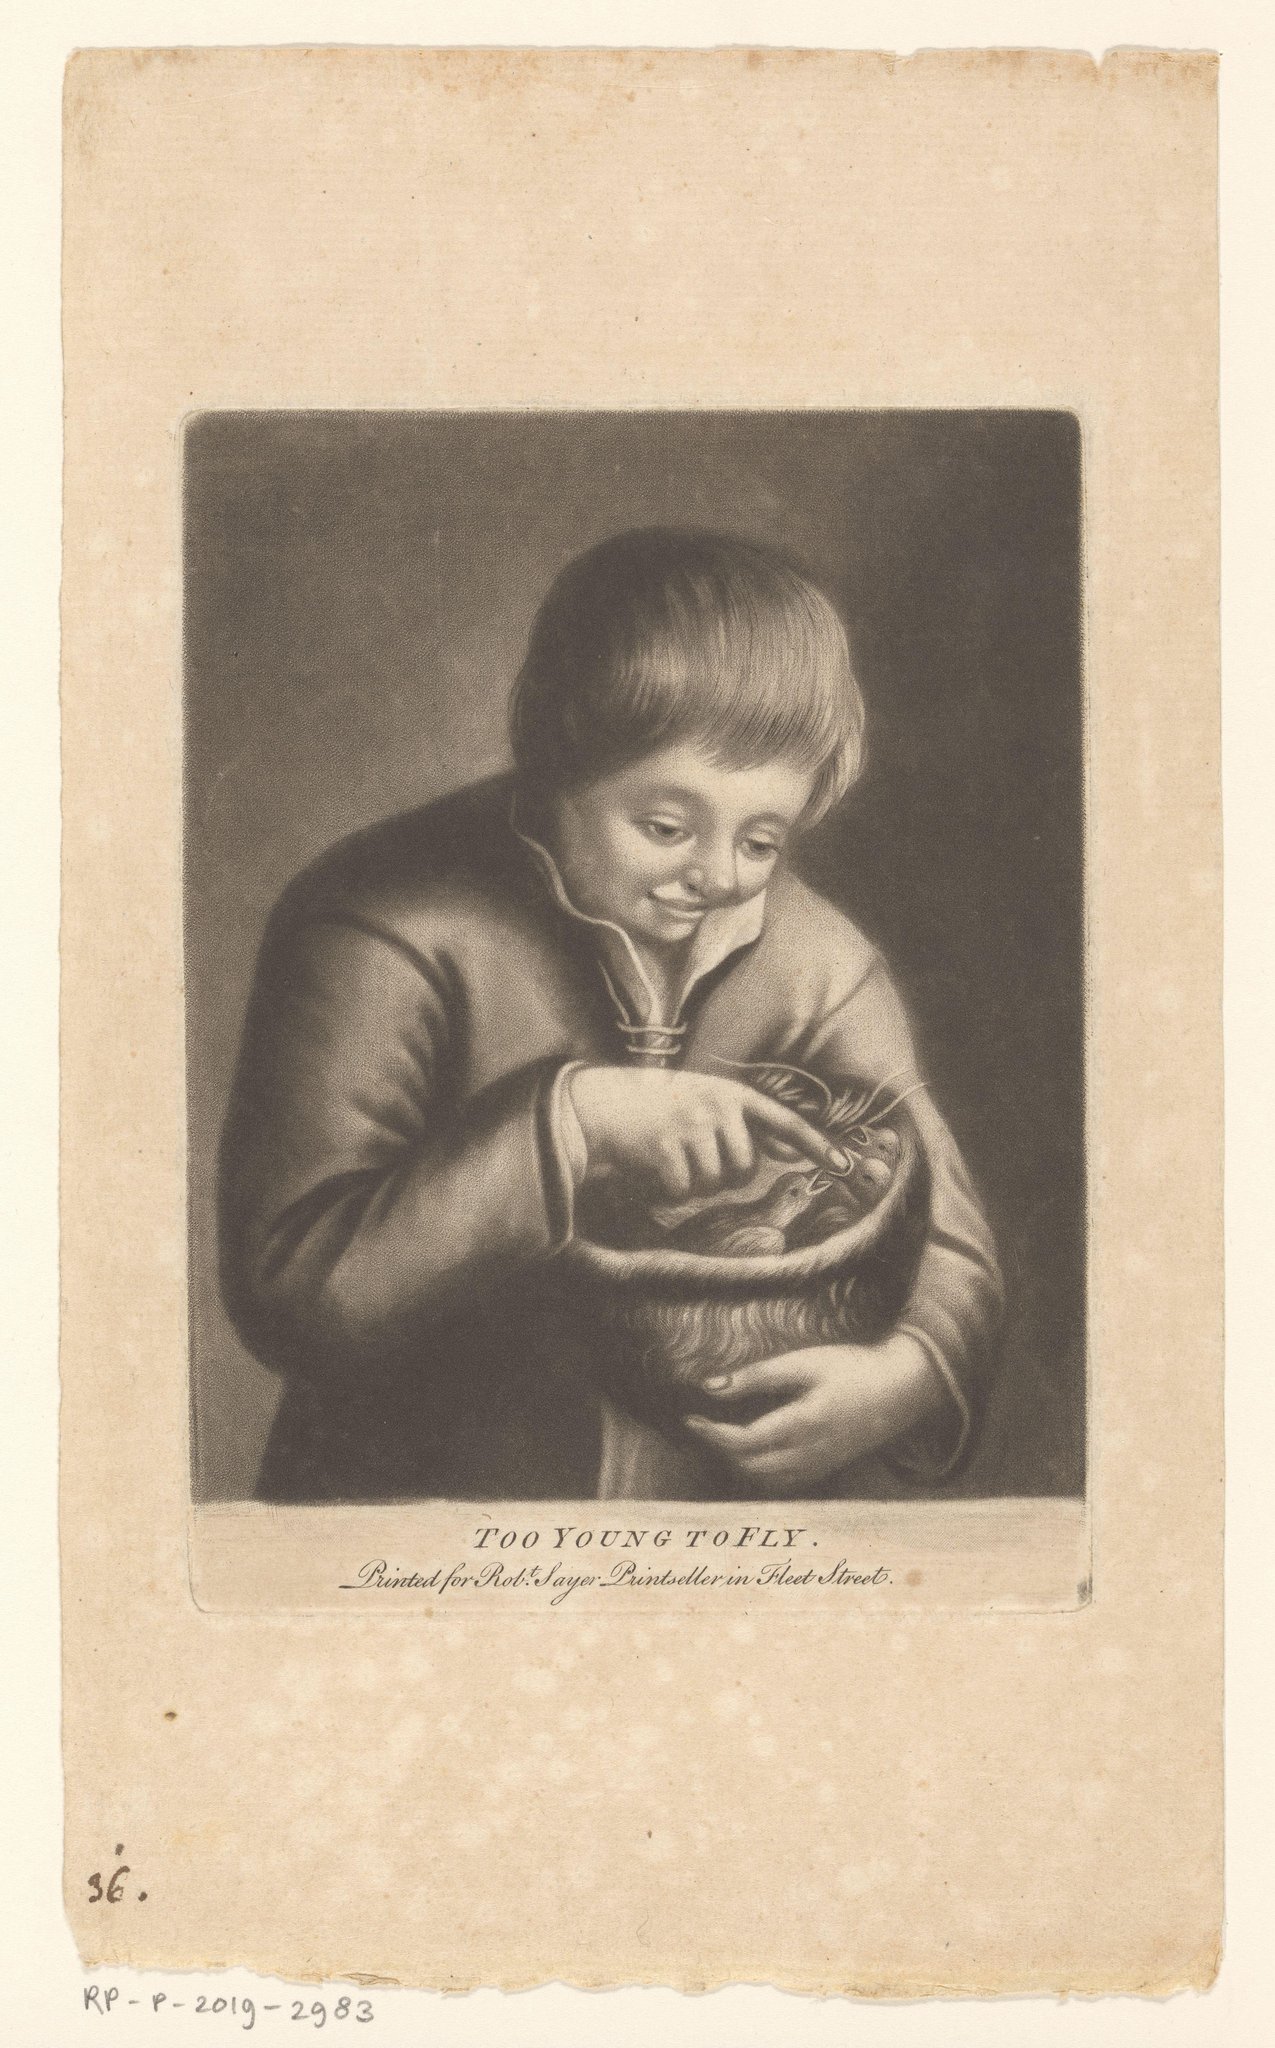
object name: print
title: Too Young to Fly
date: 1734-1794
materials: paper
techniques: etching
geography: england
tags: caring for birds, birds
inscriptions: collector's mark: Lugt 2228, number: ‘36.’